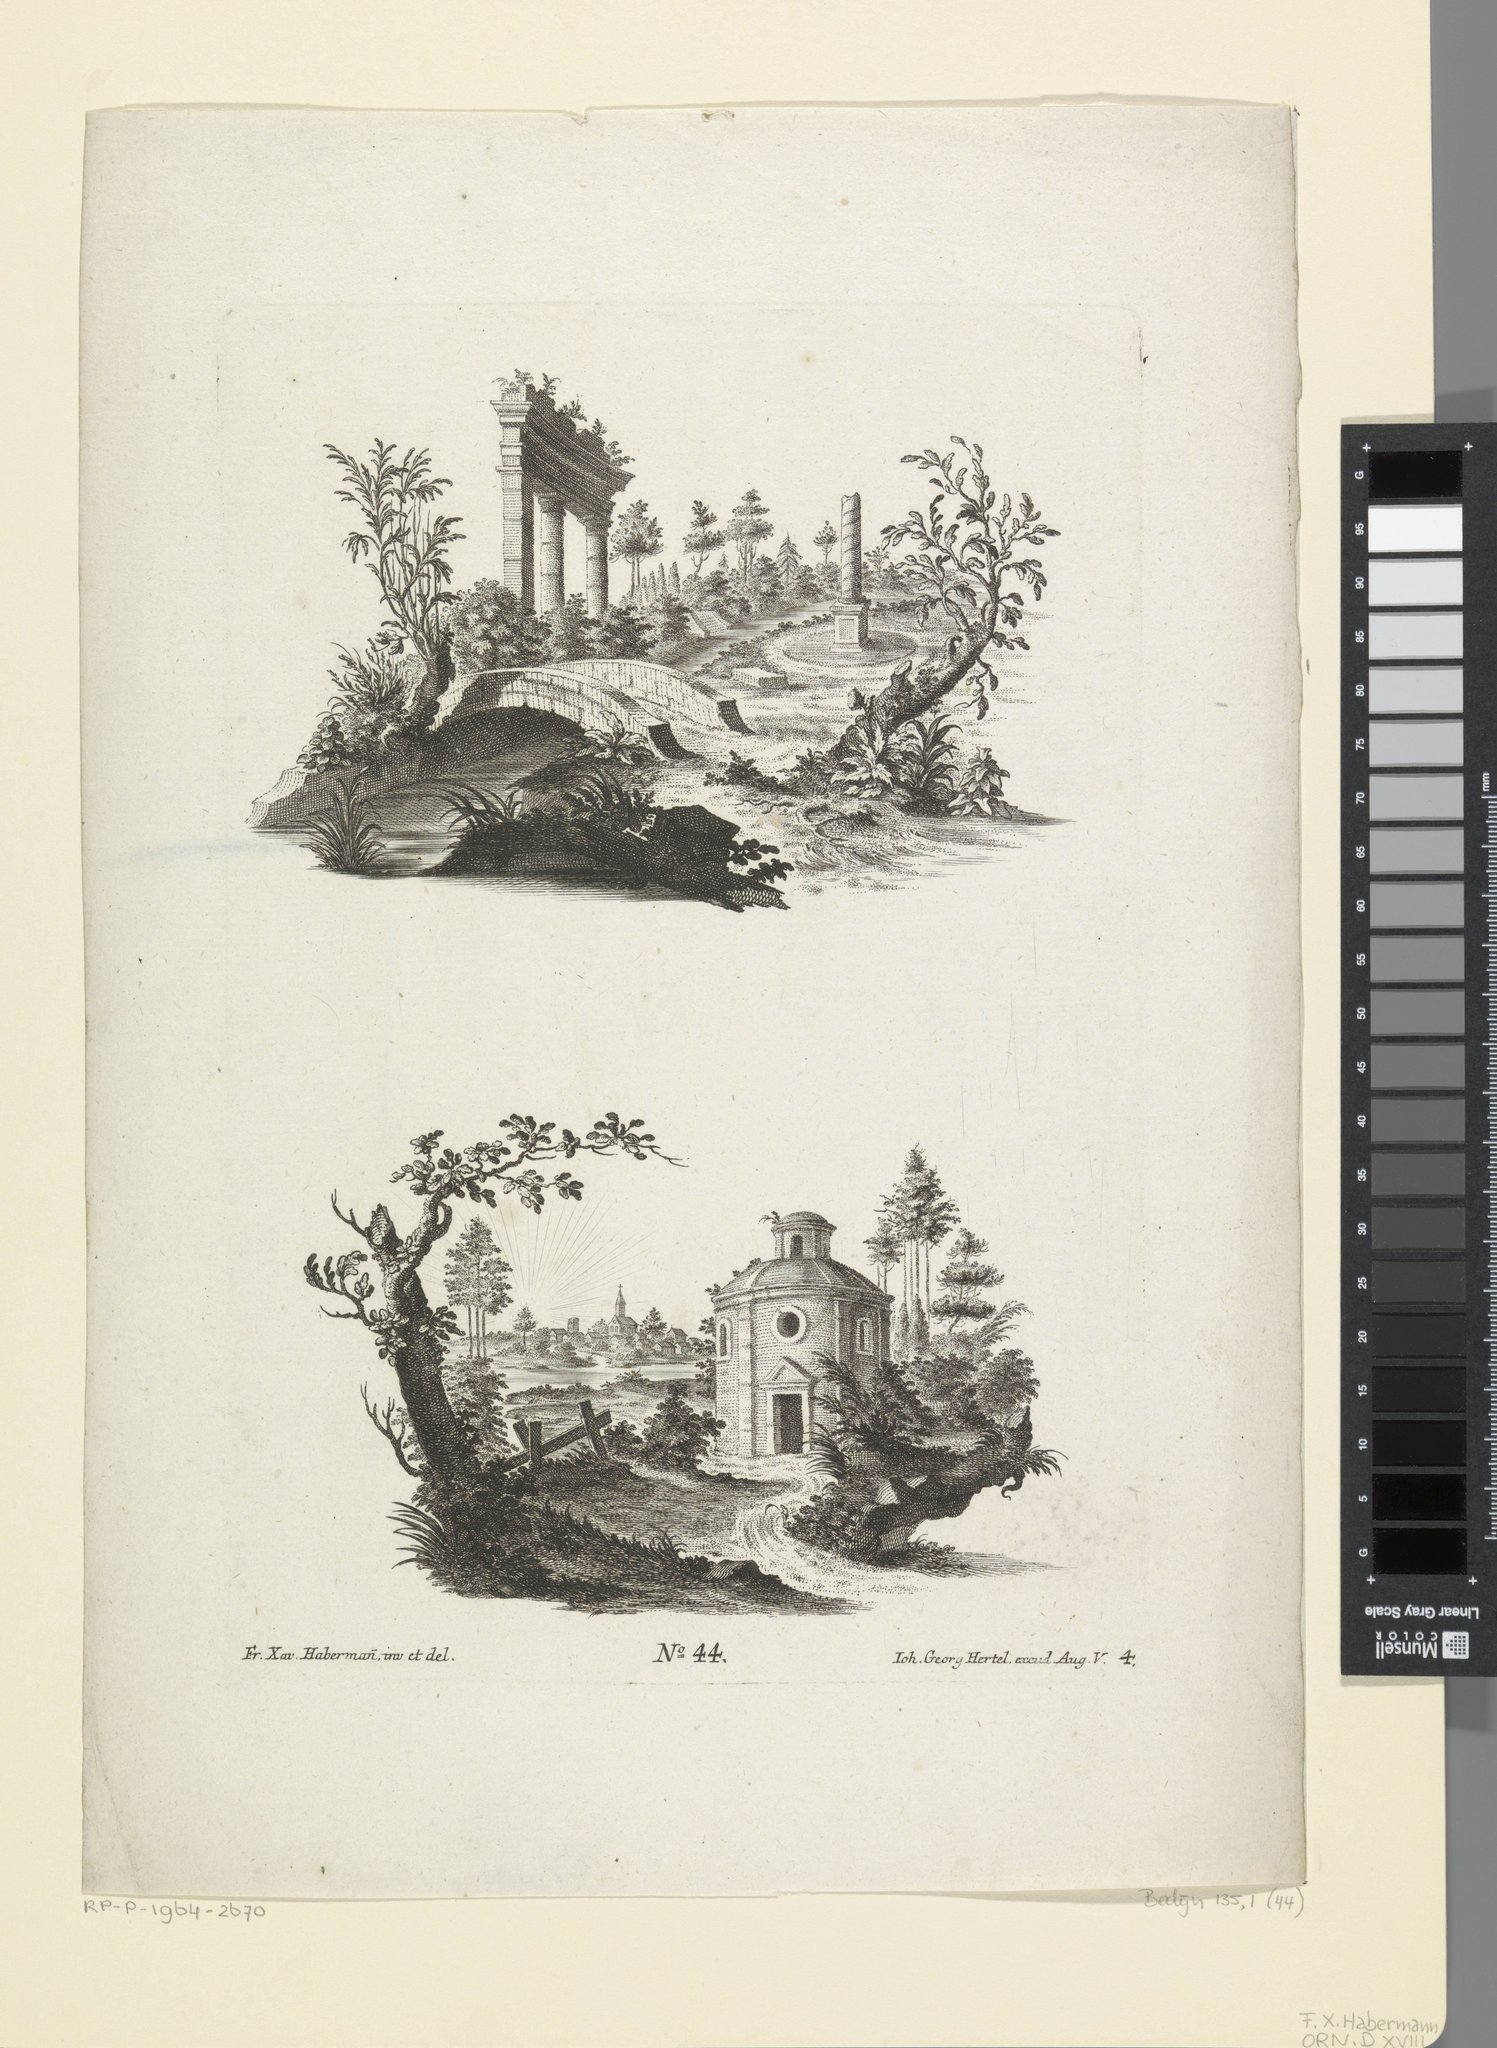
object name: ornament print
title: Landschappen met brug en zuilen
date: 1731-1775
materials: paper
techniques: etching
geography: augsburg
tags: landscapes, column, pillar ~ architecture, ideal and visionary architecture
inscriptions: collector's mark: Lugt 2228, collector's mark: Lugt 2760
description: Twee decoratieve landschappen. Boven een landschap met zuilen en brug over rivier. In het onderste landschap een rond gebouw. Uitgeversnummer 44.